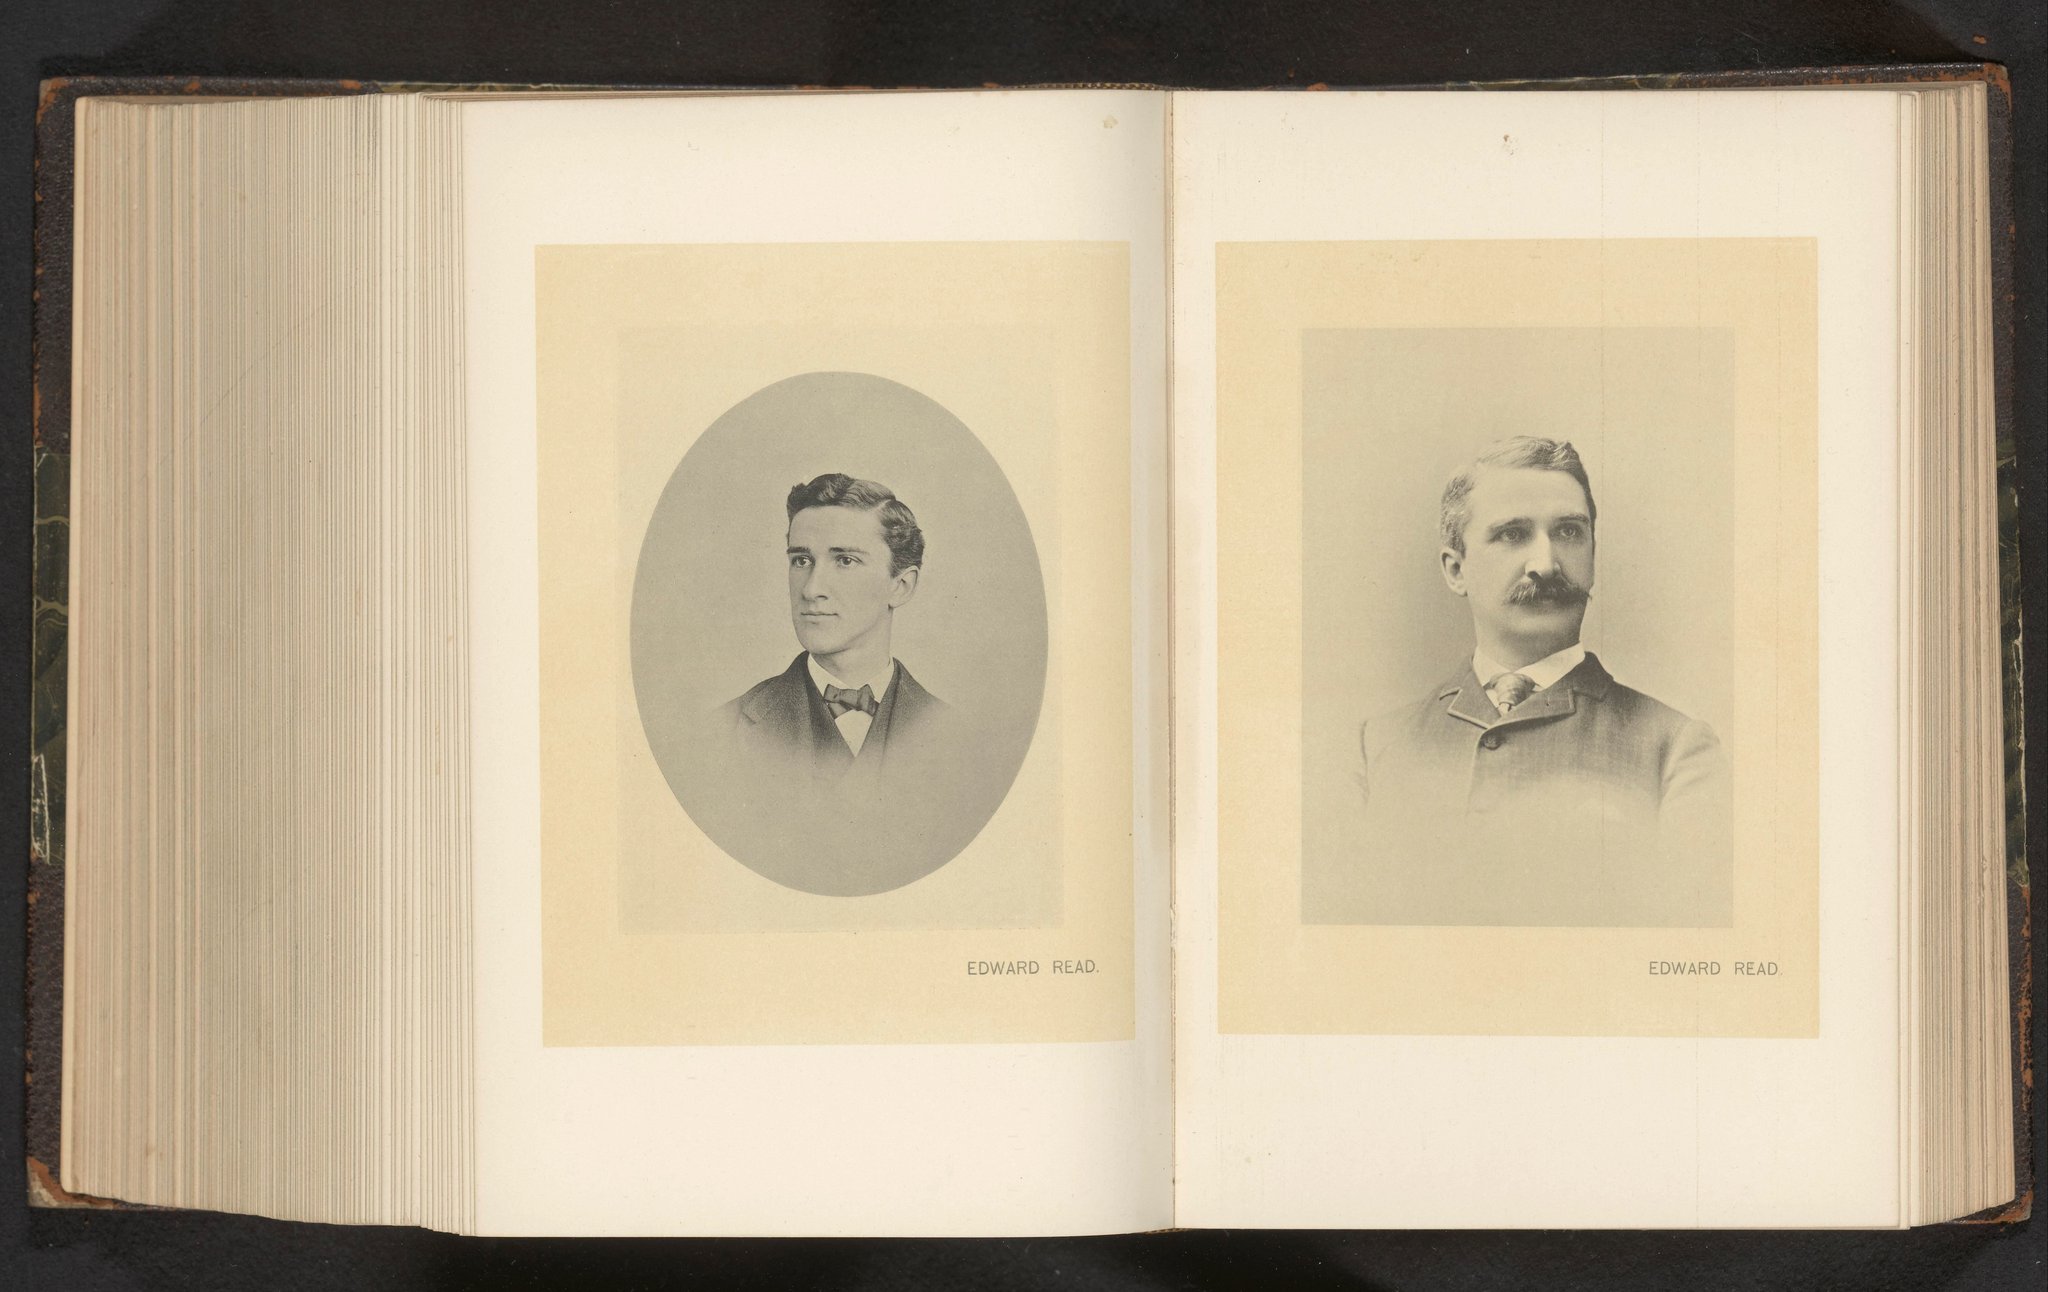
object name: photomechanical print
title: Edward Read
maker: Anonymous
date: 1869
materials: paper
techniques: photoaquatint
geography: boston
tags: adult man